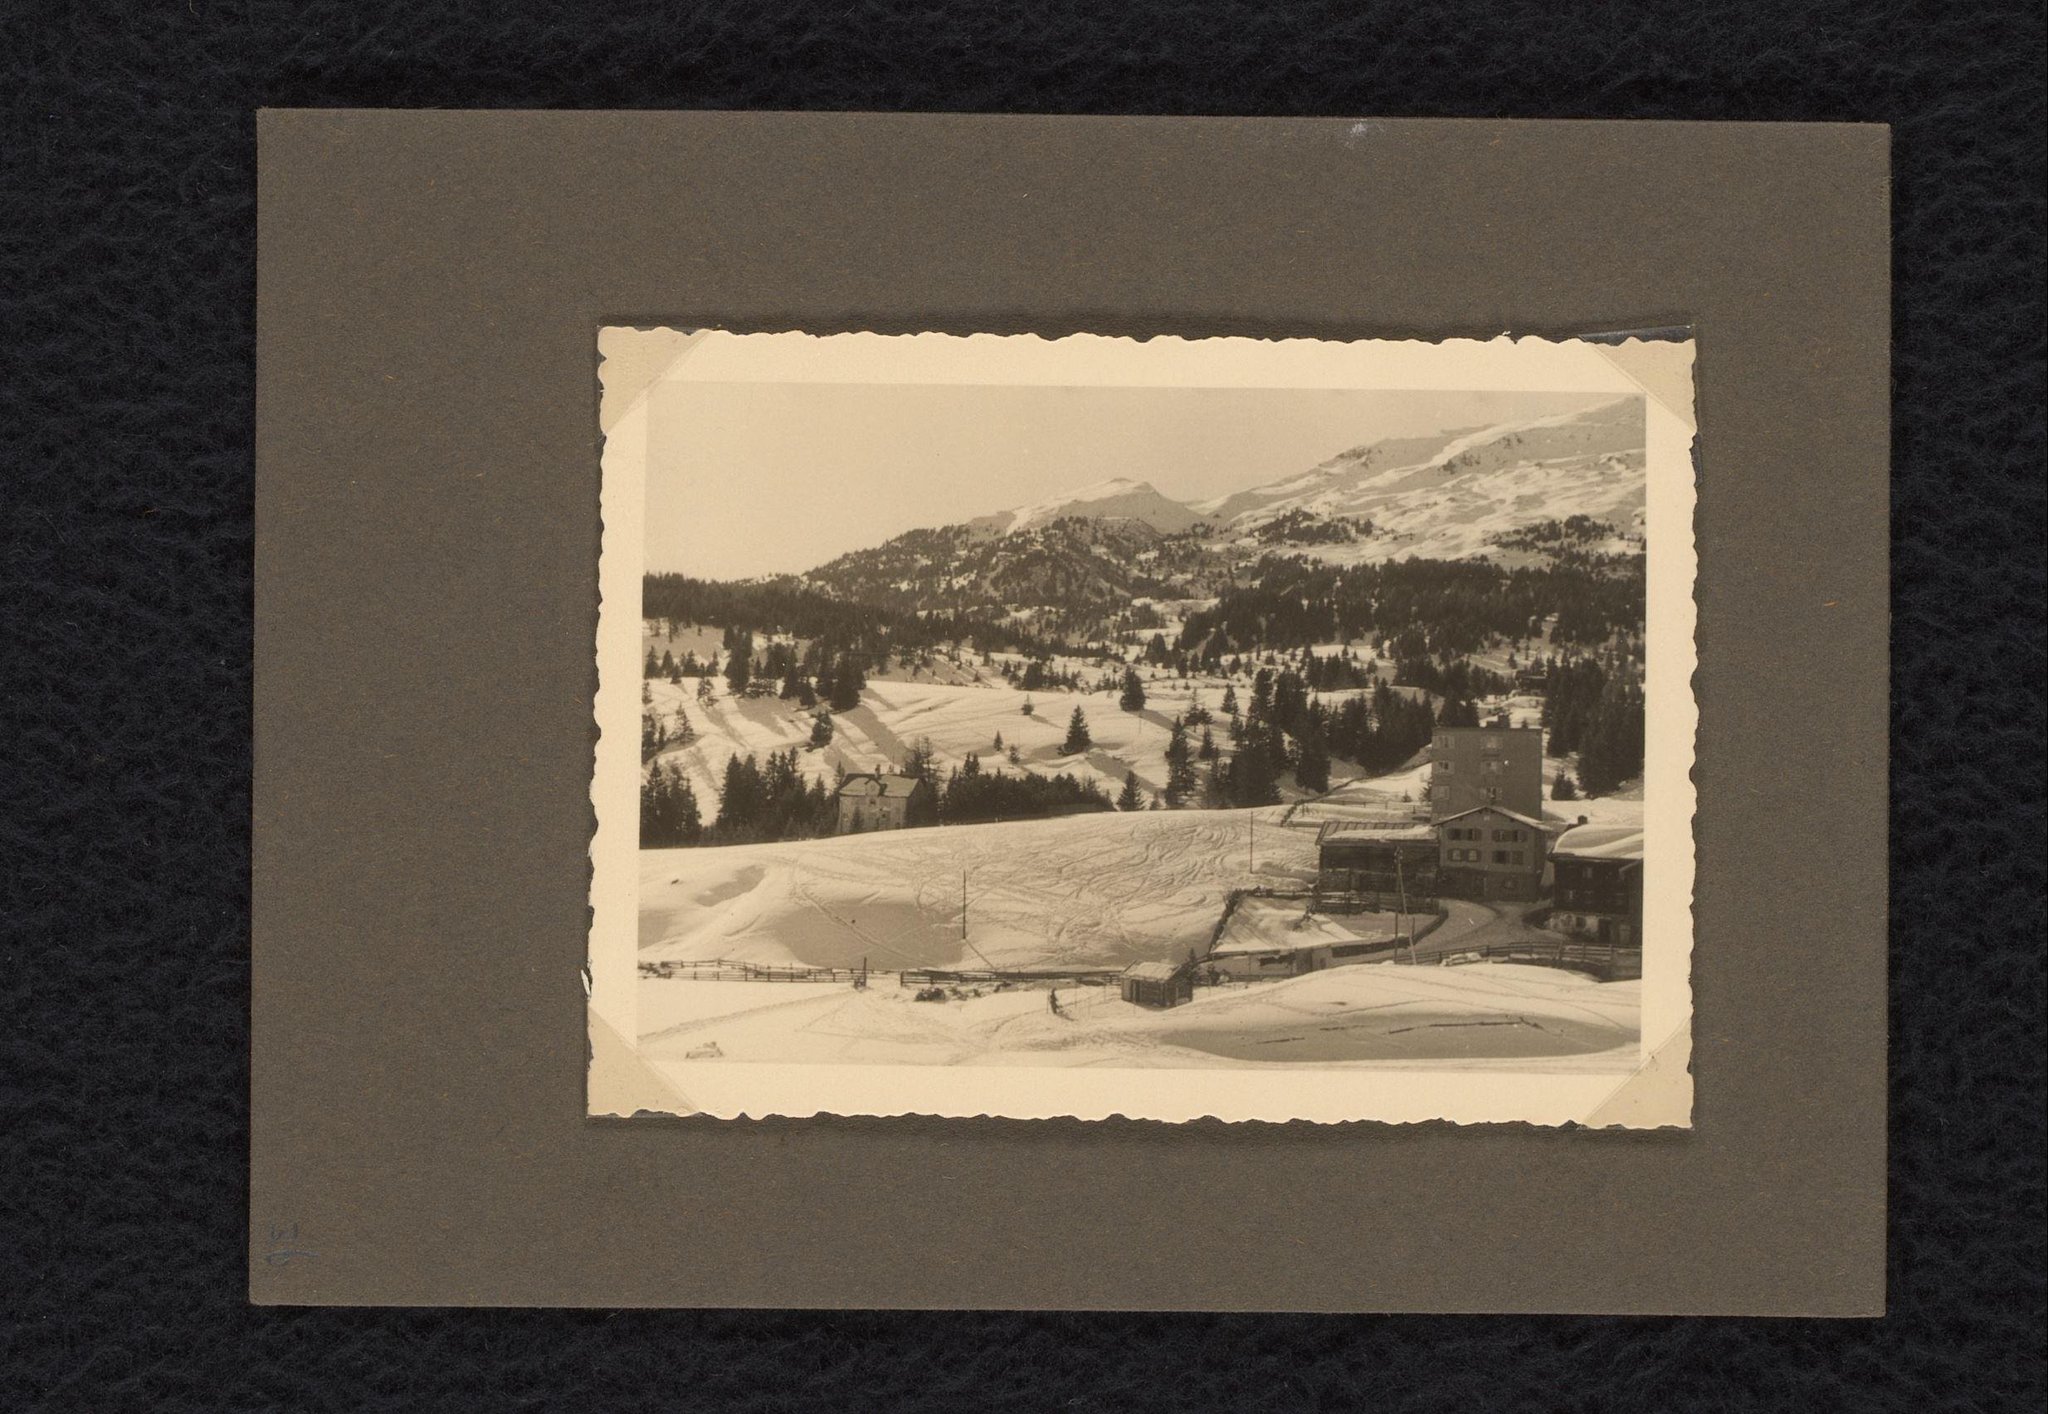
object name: album leaf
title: Piste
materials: cardboard, photographic support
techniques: gelatin silver print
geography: lenzerheide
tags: isabel wachenheimer-elon, skis (winter sports), the family travelling, on holiday, snow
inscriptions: date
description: Albumblad met een foto van de skipiste. Onderdeel van het fotoalbum met vakantiefoto's Lenzerheide, 1934.